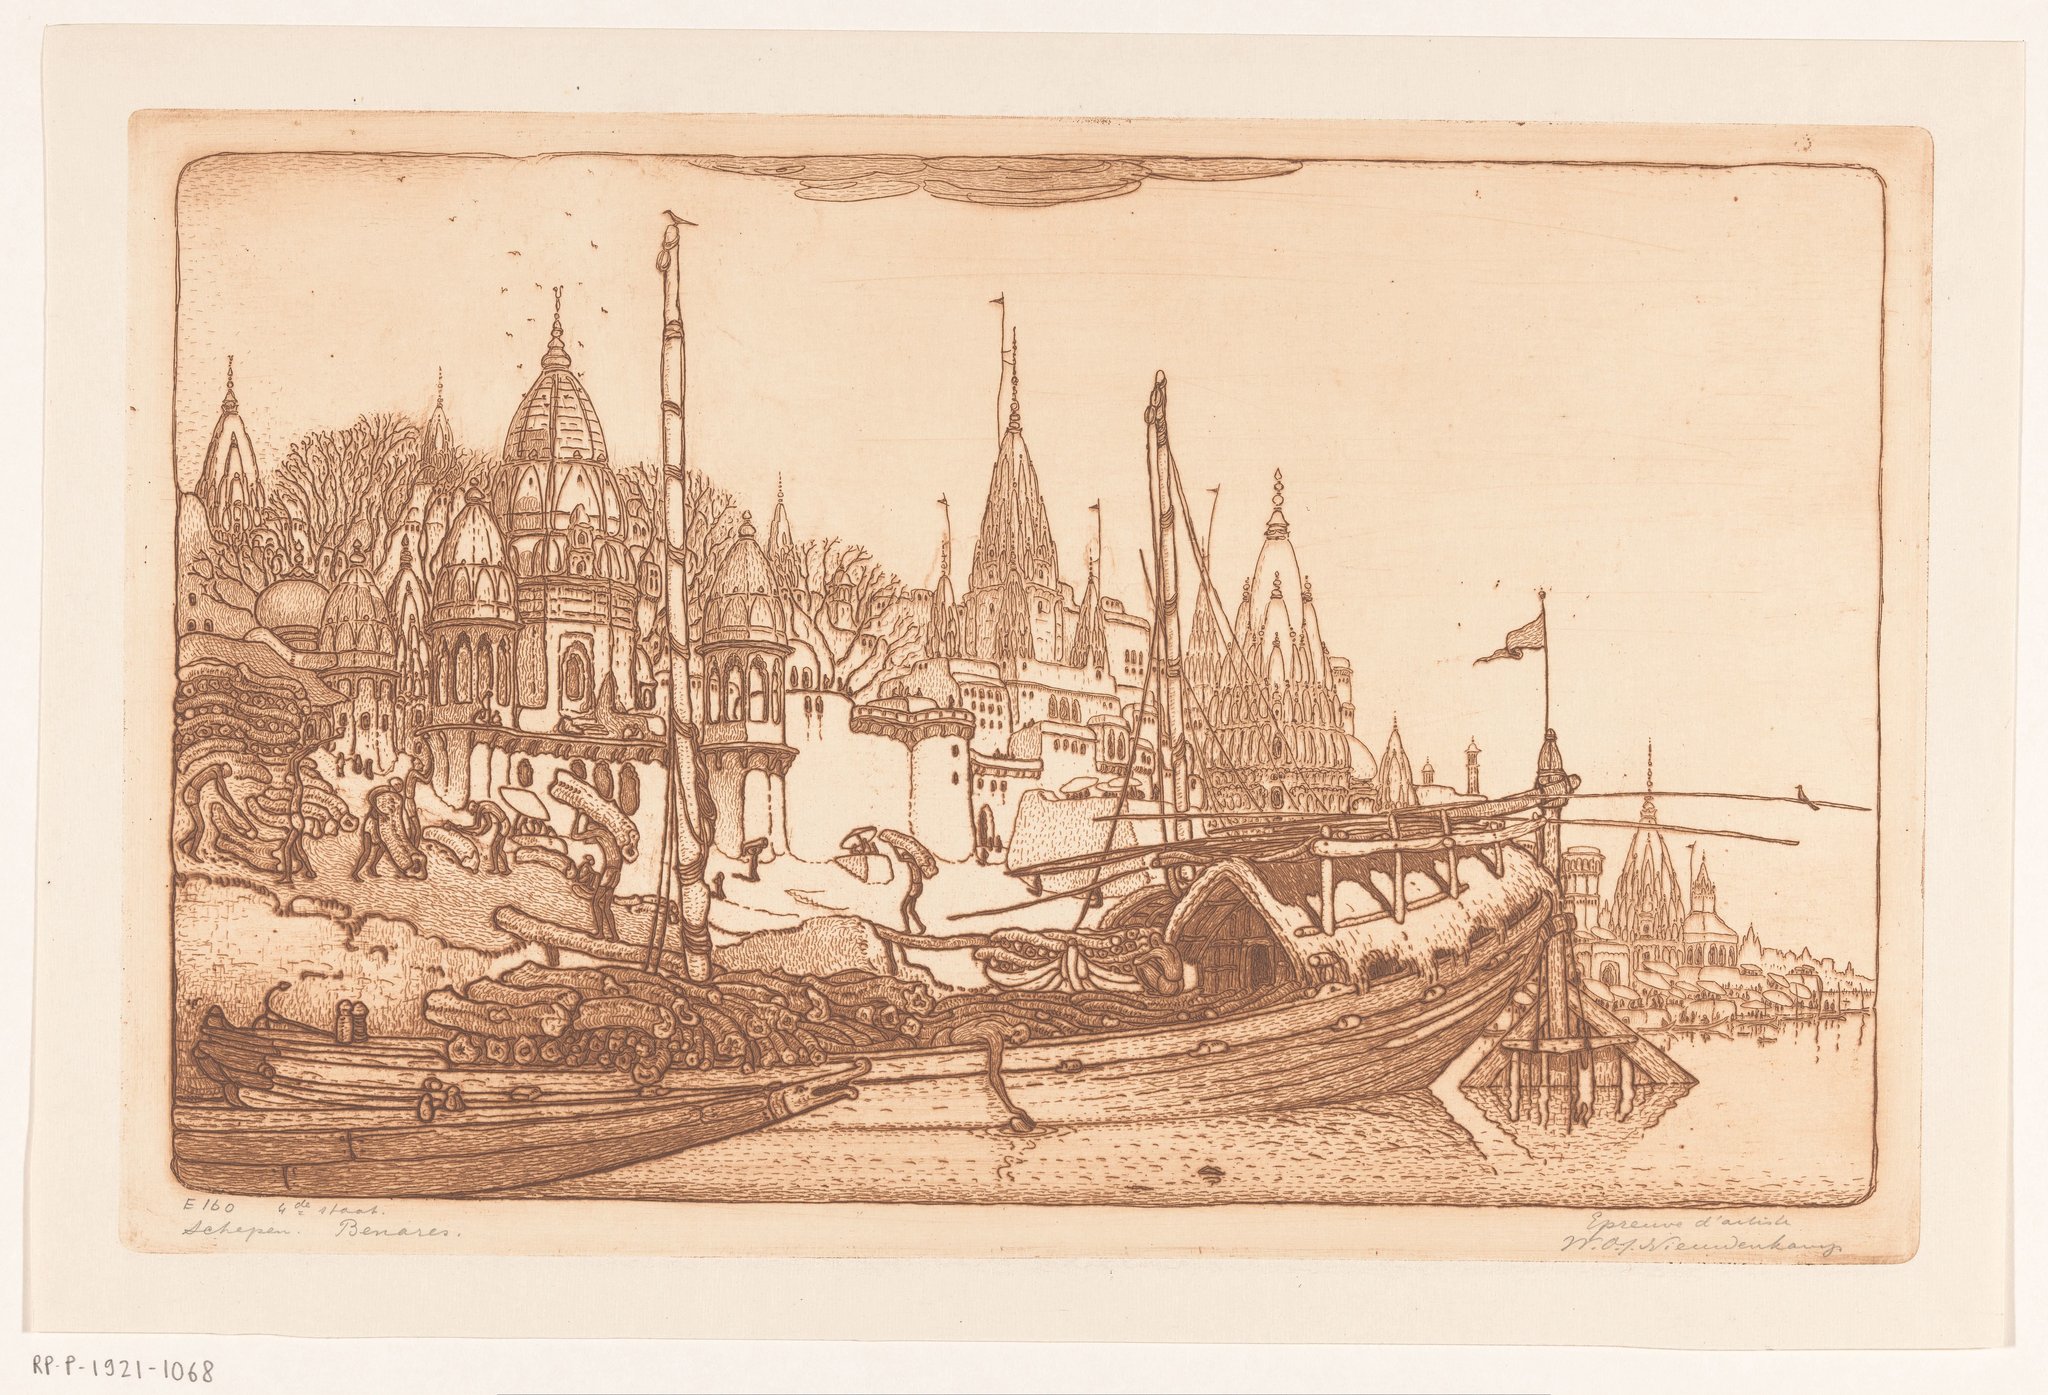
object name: print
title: Schip met brandhout, Benares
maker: wijnand otto jan nieuwenkamp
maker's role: draughtsman, print maker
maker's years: 1874-1950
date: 1915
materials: paper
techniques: intaglio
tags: city-view in general; 'veduta', river, woodcutting, woodcutter ~ forestry, ships (in general)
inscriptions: collector's mark: Lugt 2233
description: Op de oever hakken mannen het hout in stukken. Op de achtergrond enkele tempels en paleizen.